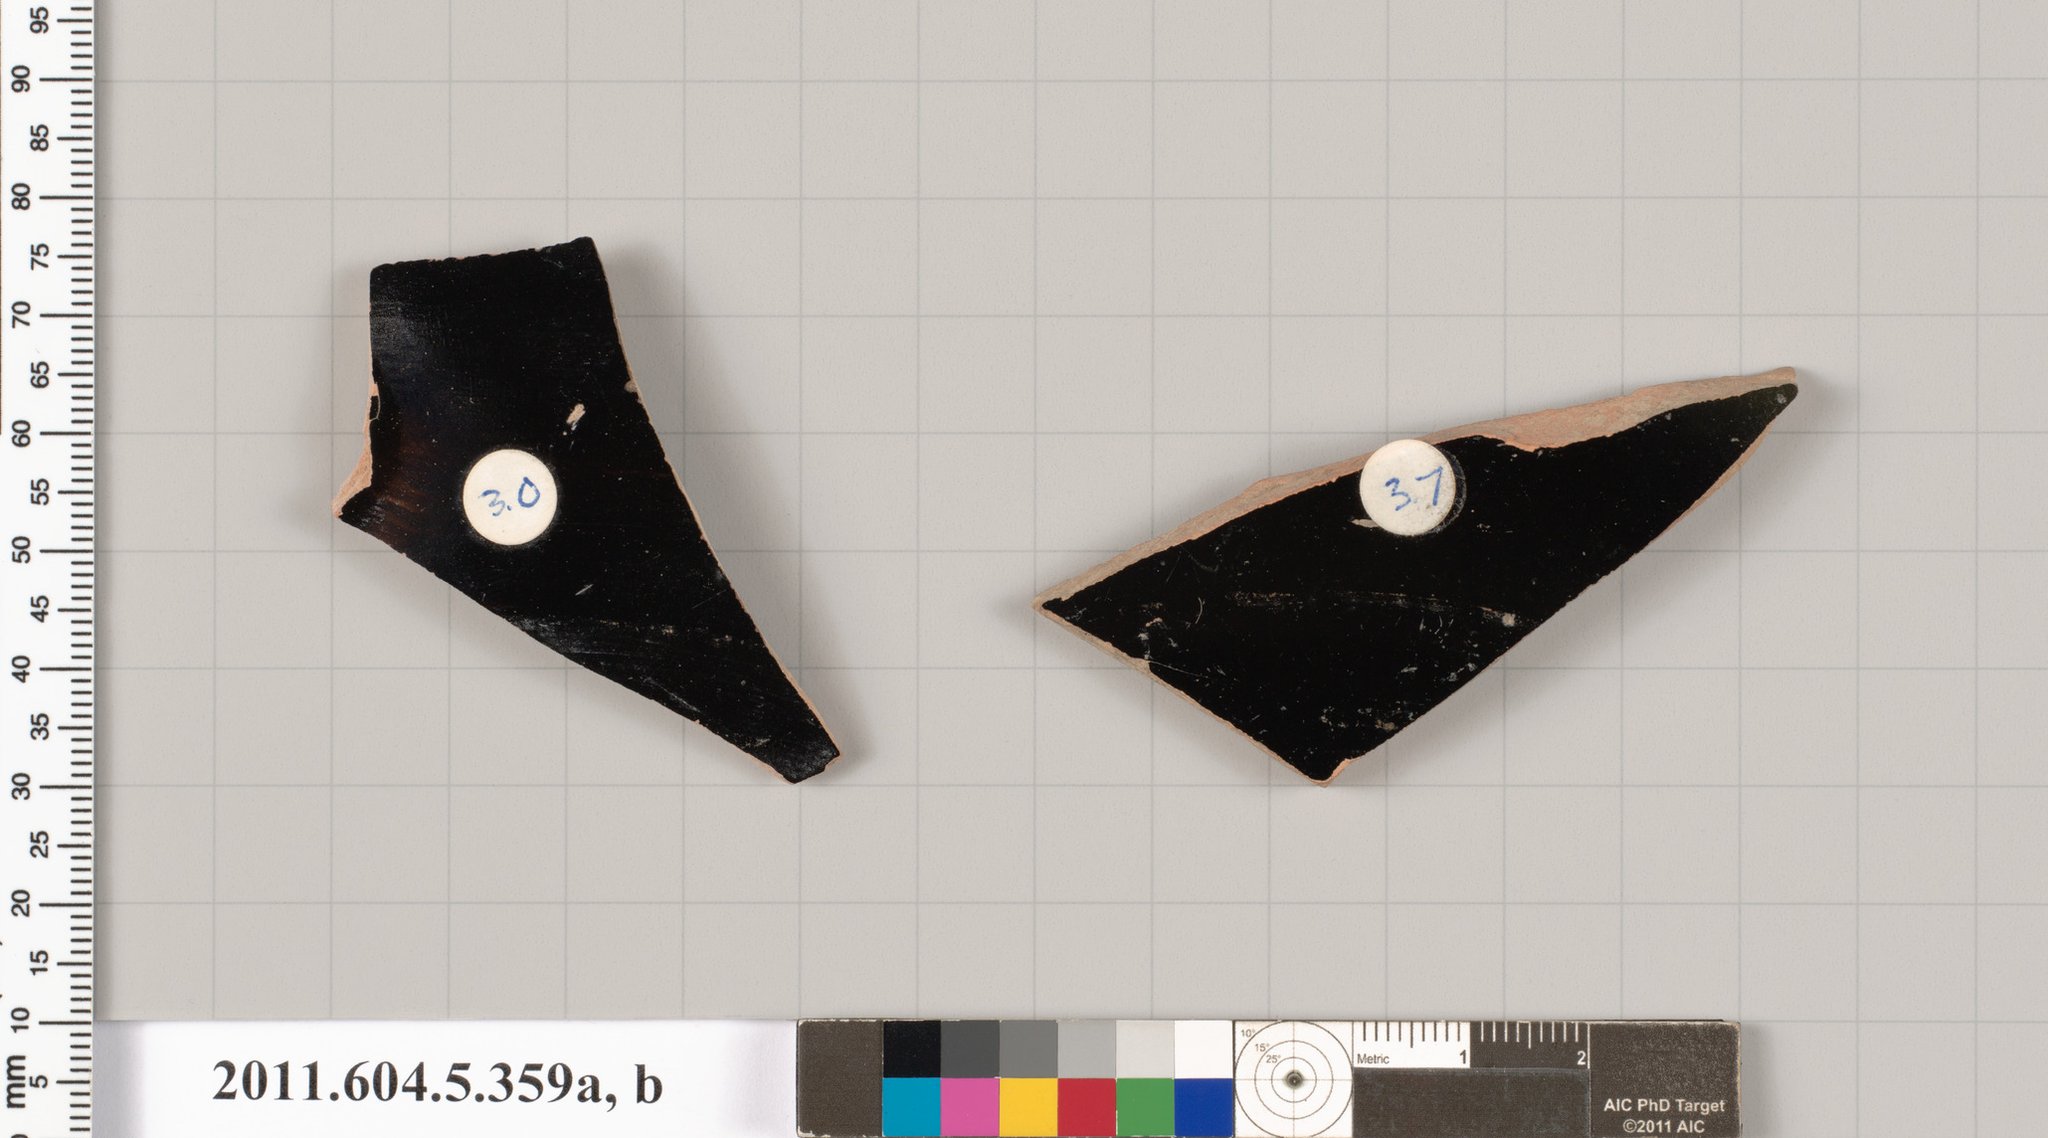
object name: kylix fragment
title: Terracotta fragments of kylikes (drinking cups)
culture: greek, attic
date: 600-401 BCE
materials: terracotta